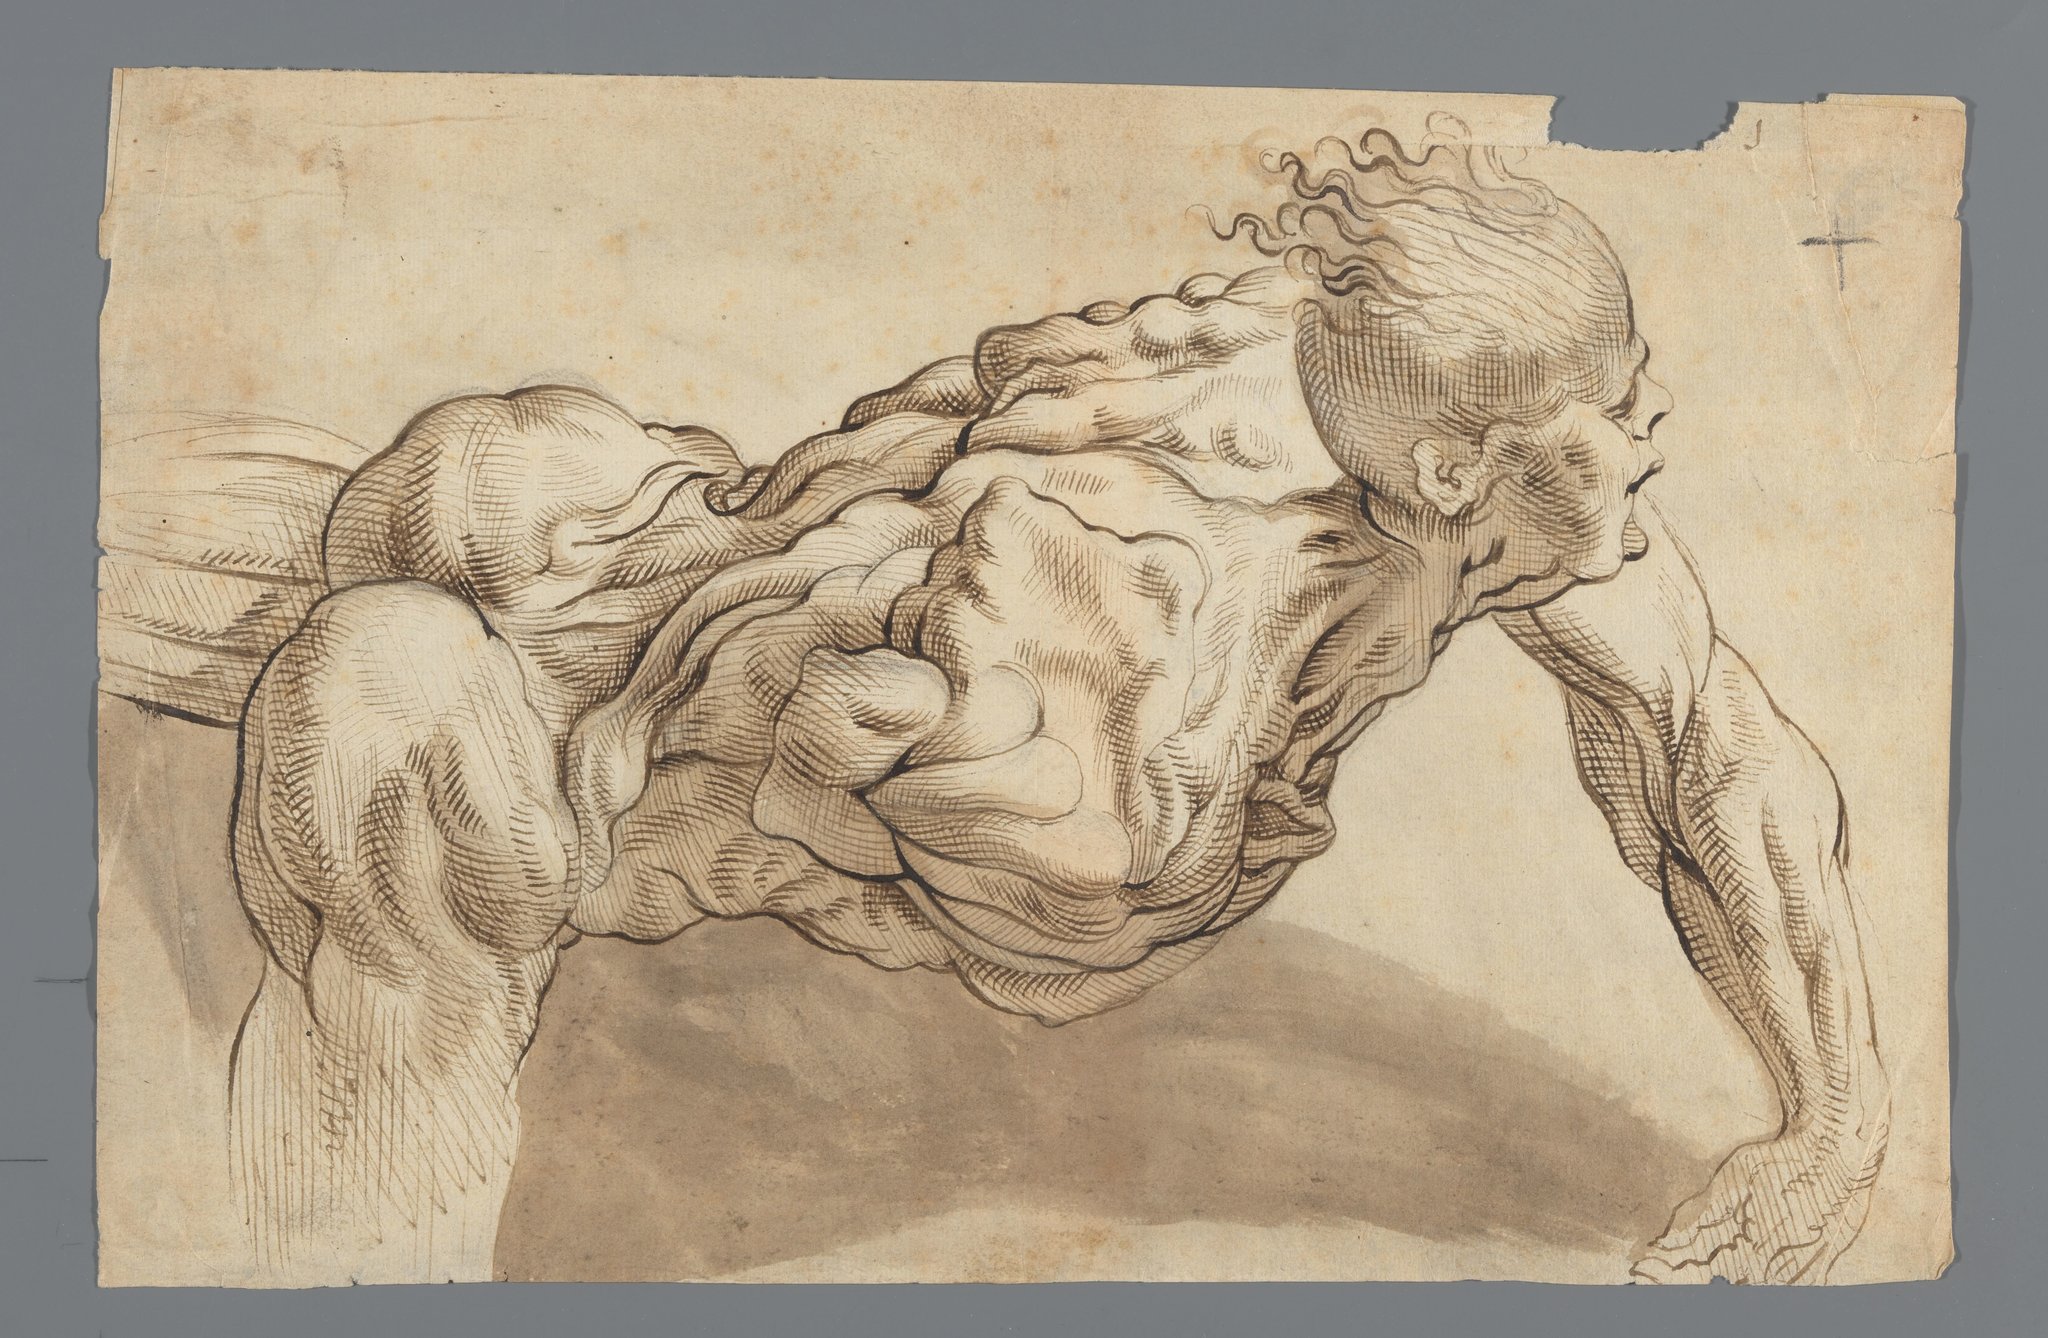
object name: drawing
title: Anatomische studie van een staande man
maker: Anonymous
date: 1700-1800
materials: ink, paper, pencil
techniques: brush, pen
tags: anatomical models (usually series of five figures)